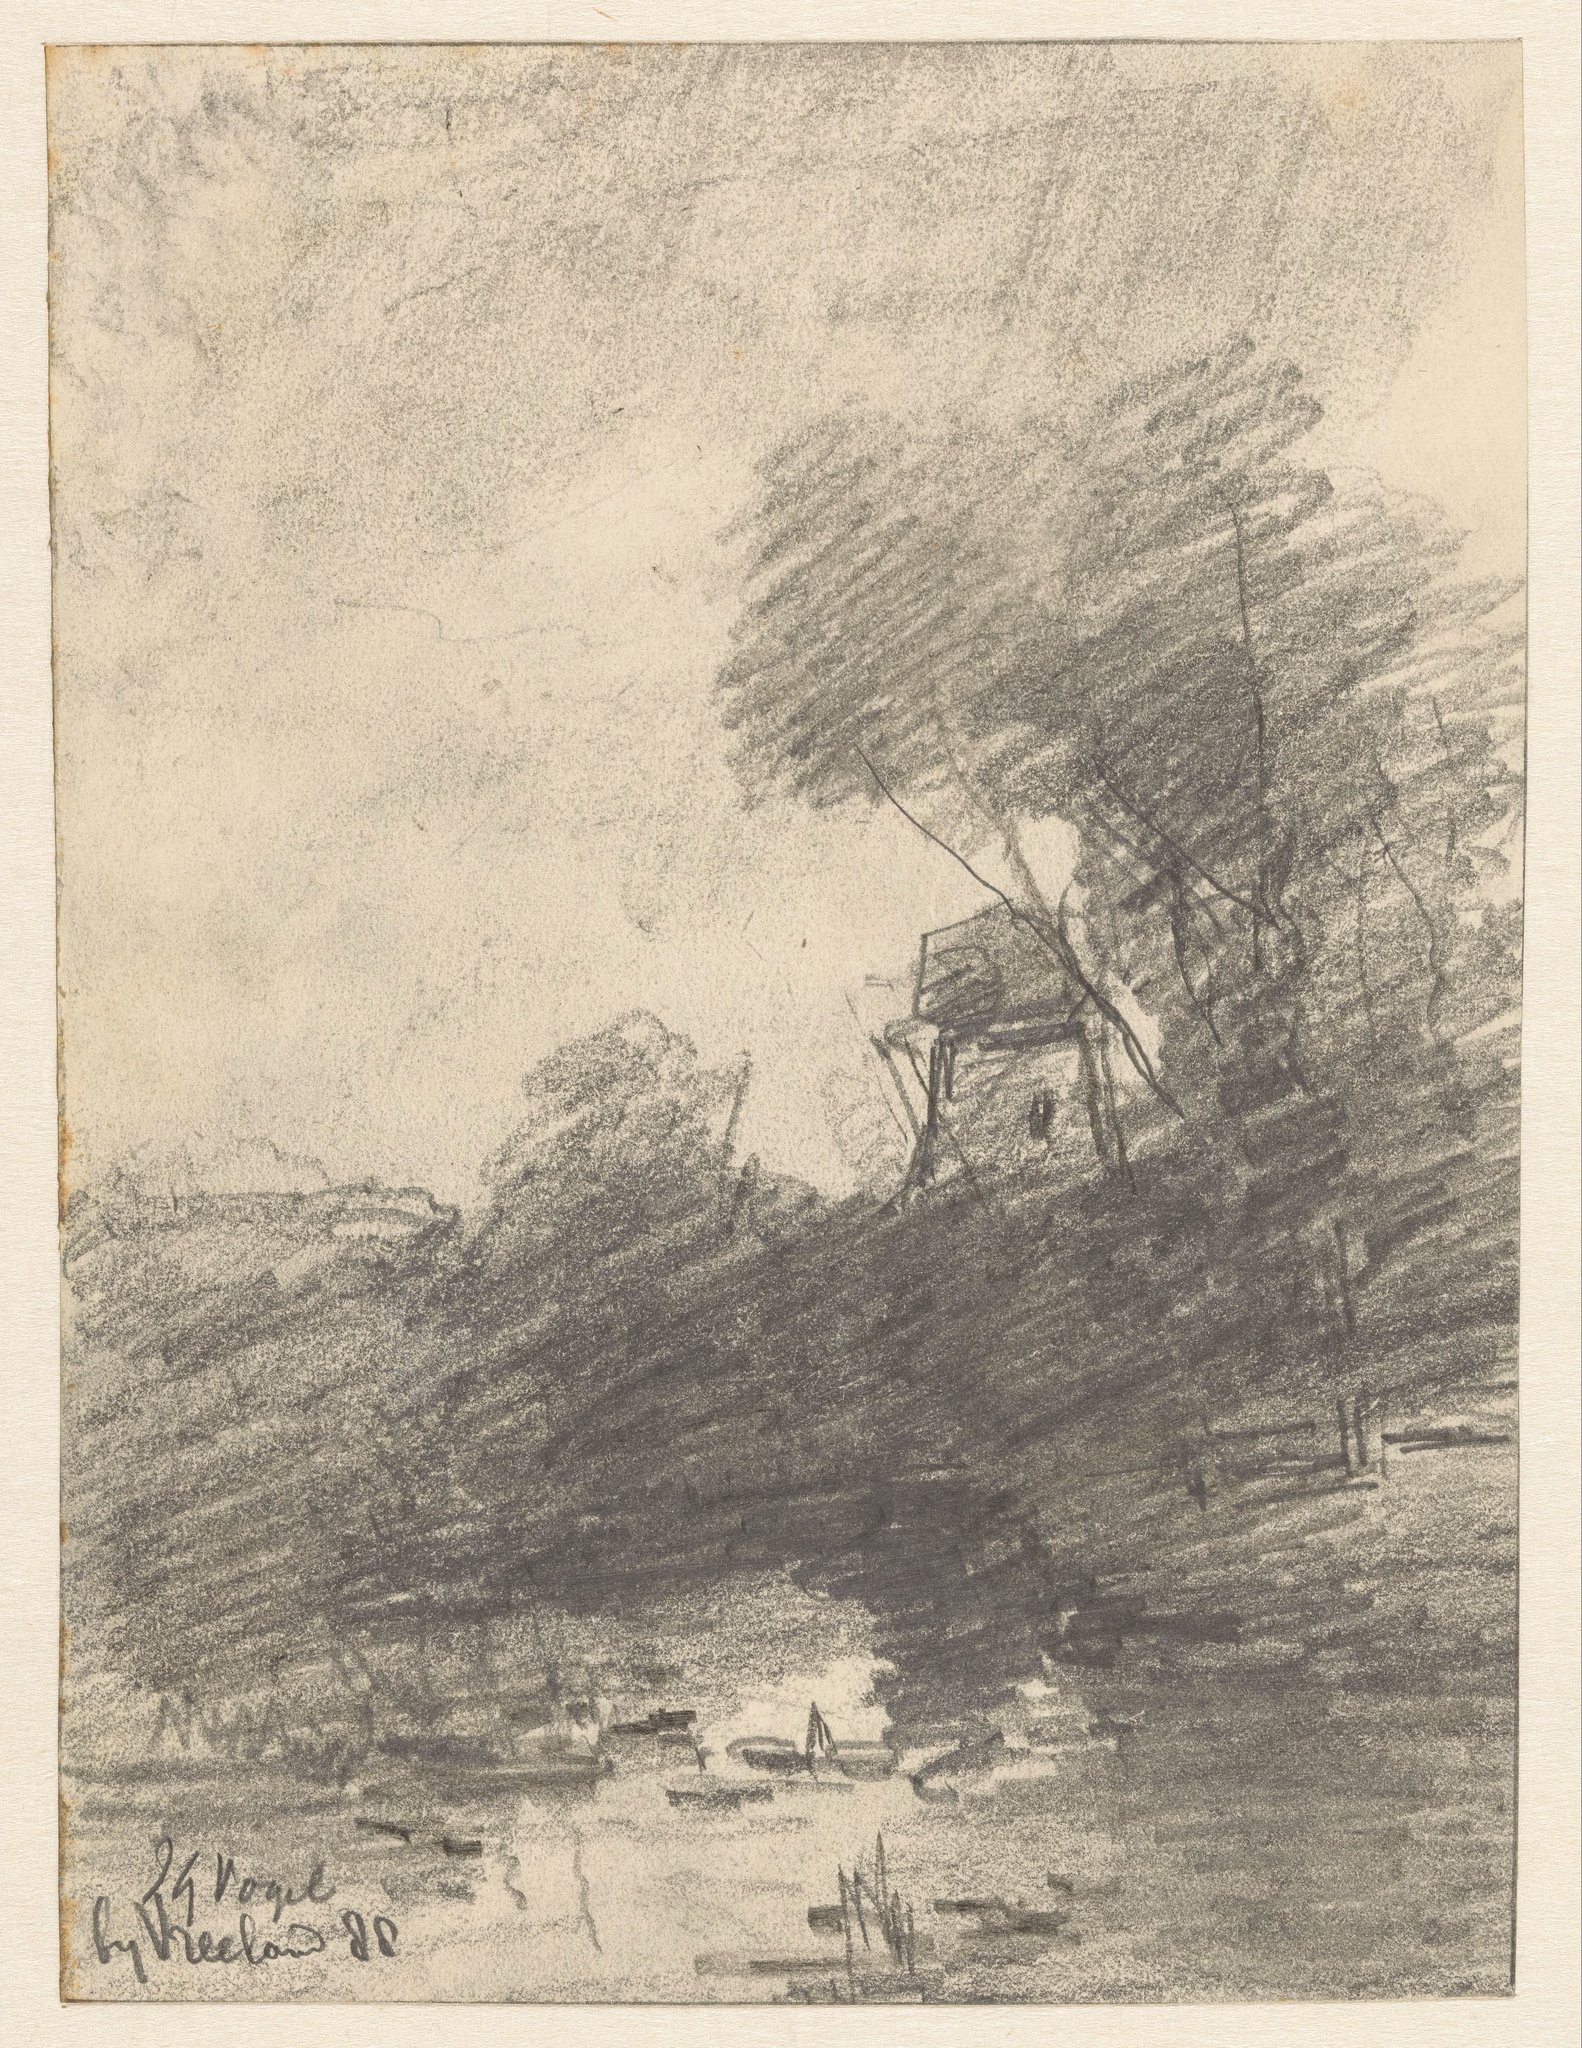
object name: drawing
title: Molen tussen bomen bij Vreeland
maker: johannes gijsbert vogel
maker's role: draughtsman, painter, print maker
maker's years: 1828-1915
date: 1888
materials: chalk, paper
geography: vreeland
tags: landscapes in the temperate zone, windmill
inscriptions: date